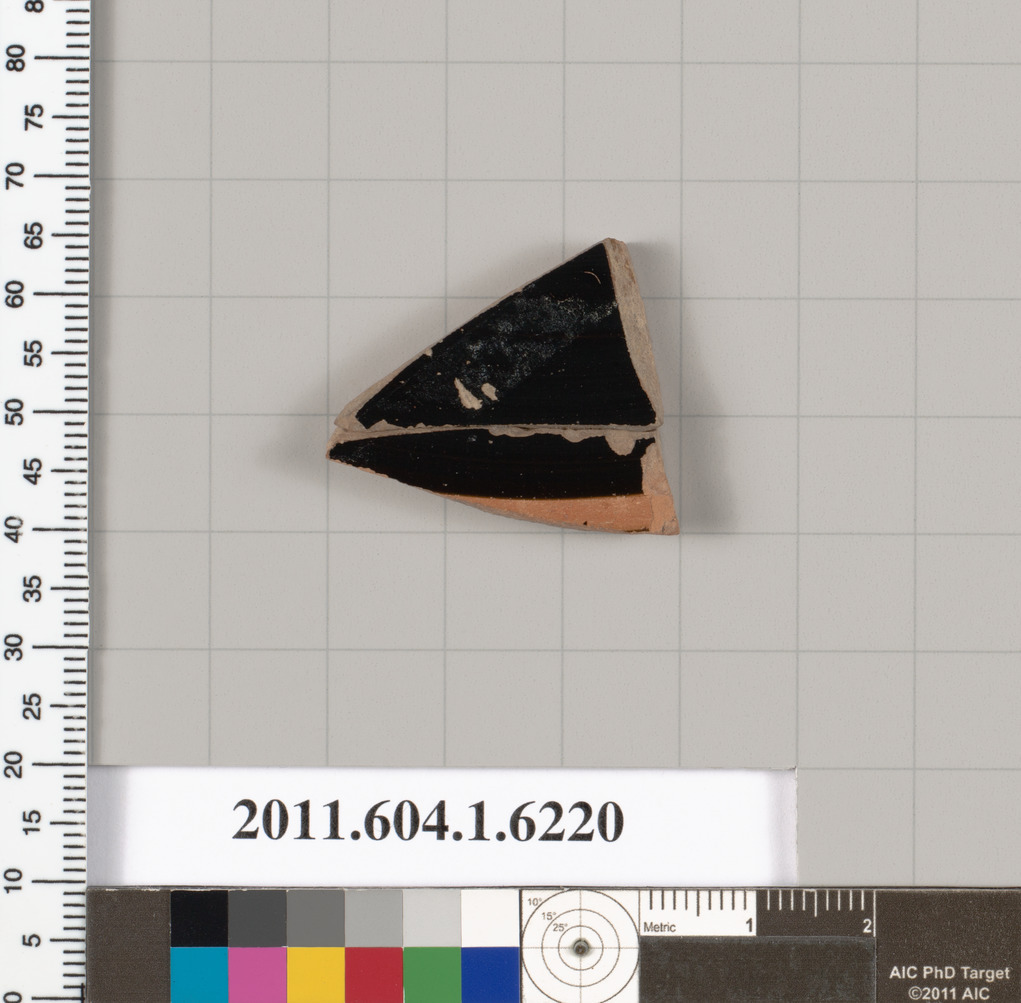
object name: kylix fragment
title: Terracotta fragment of a kylix (drinking cup)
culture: greek, attic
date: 510-500 BCE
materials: terracotta